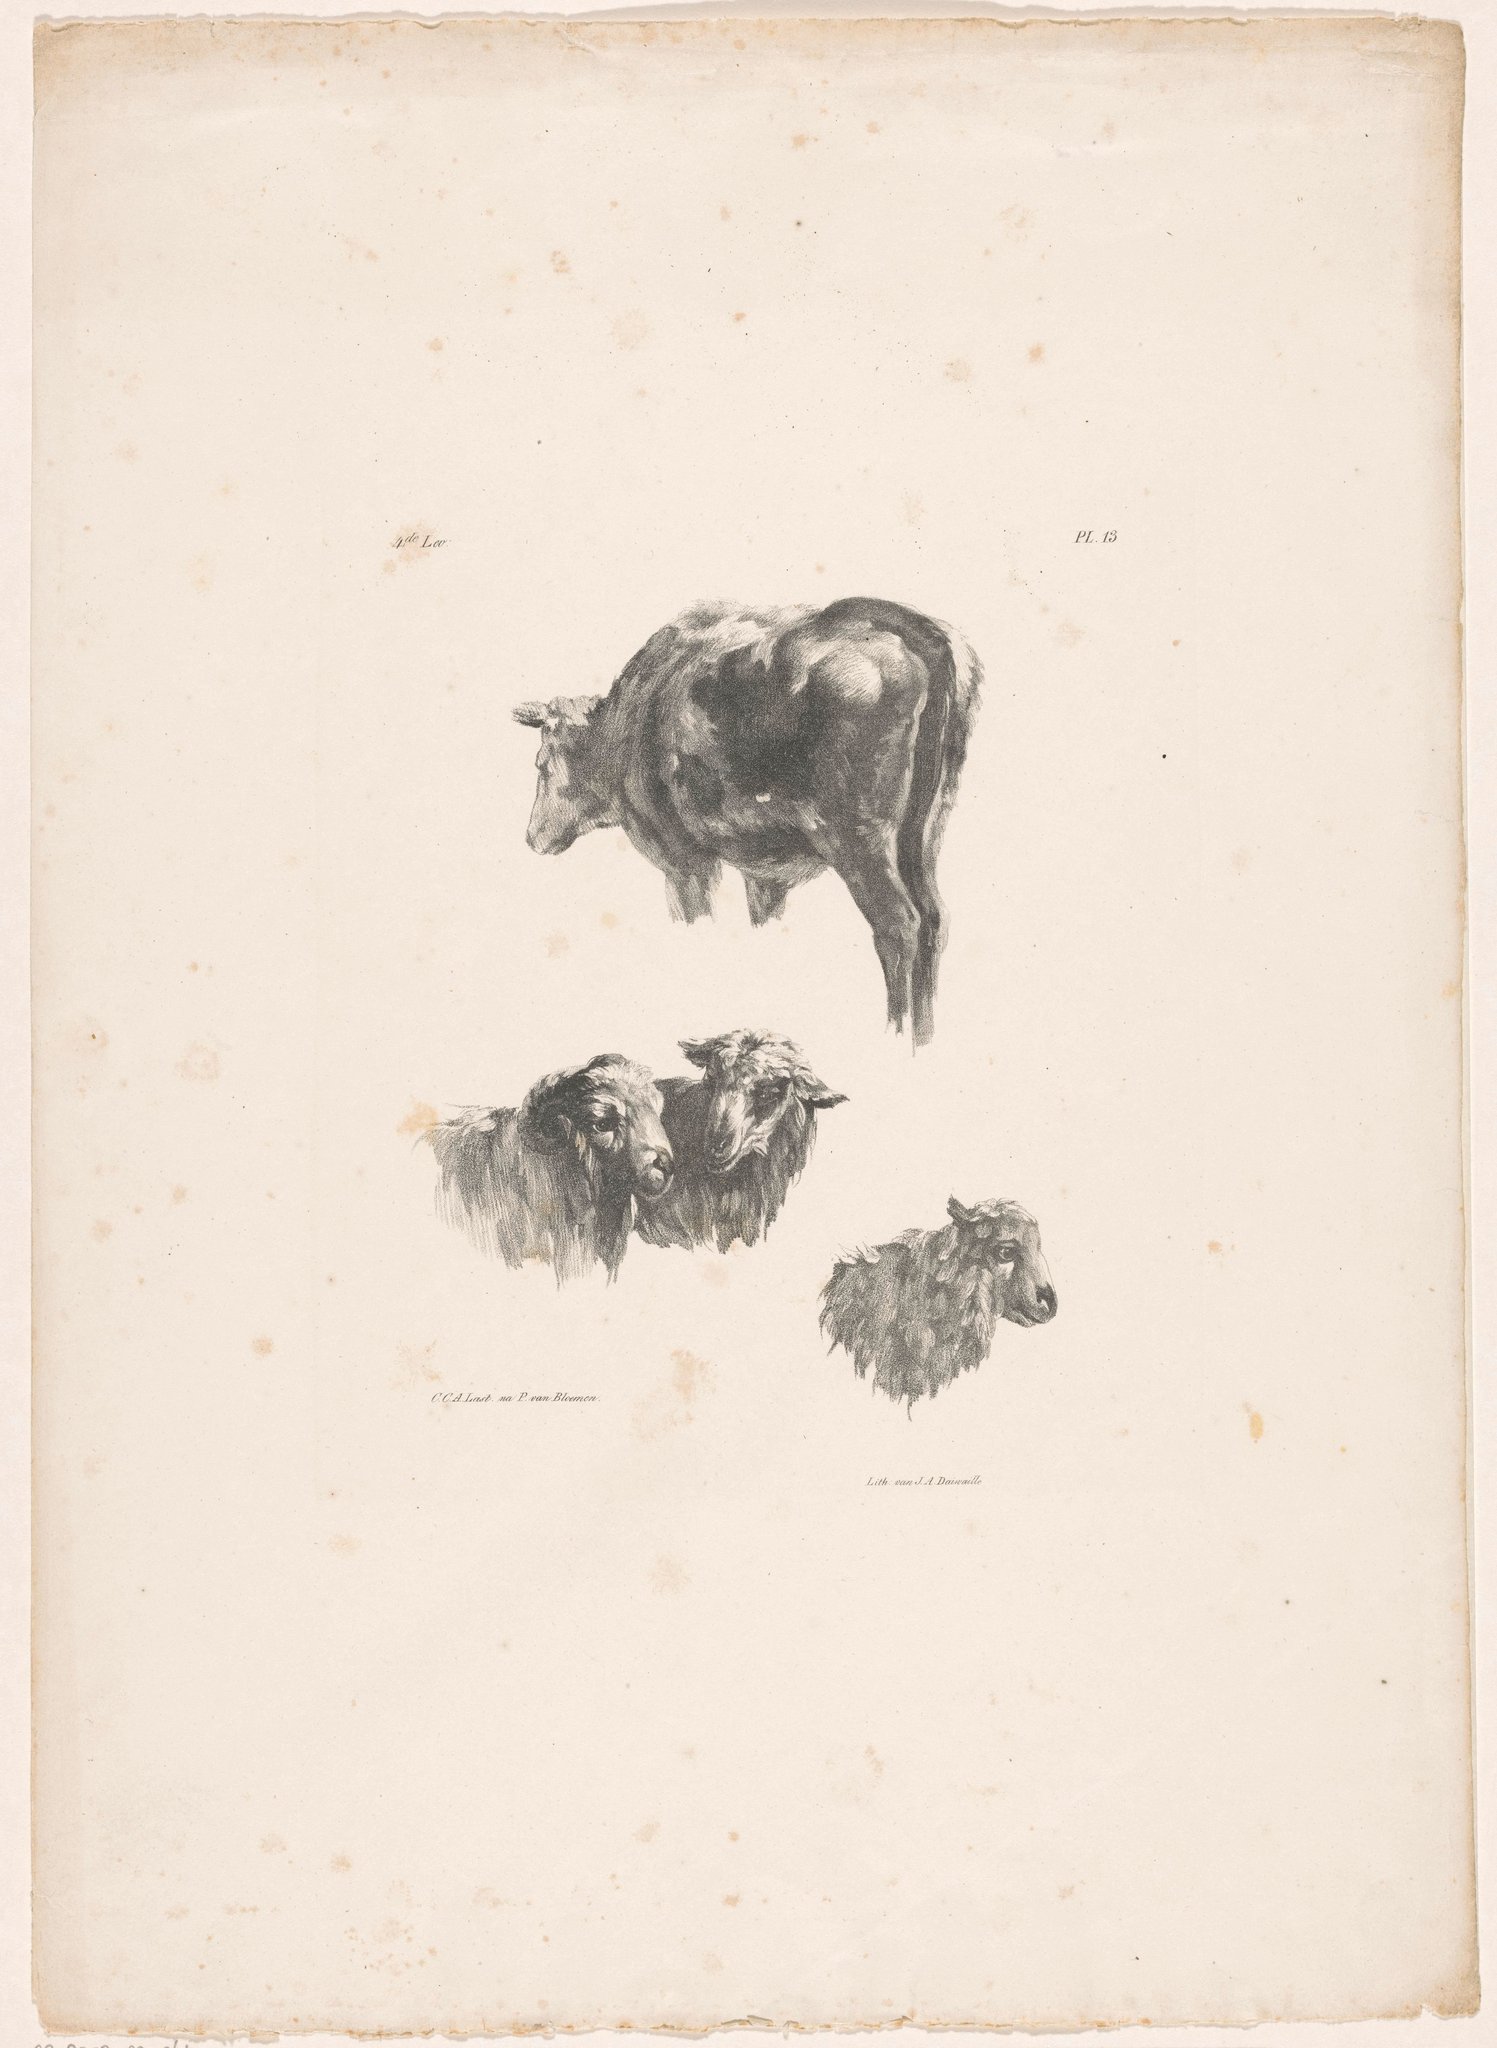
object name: print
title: Rund, twee schapen en een ram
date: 1818-1876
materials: paper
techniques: lithograph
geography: amsterdam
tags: cow, sheep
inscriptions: collector's mark: Lugt 2228, watermark: ‘Zoonen’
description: Genummerd links- en rechtsboven: '4de Lev' en 'Pl. 13'.